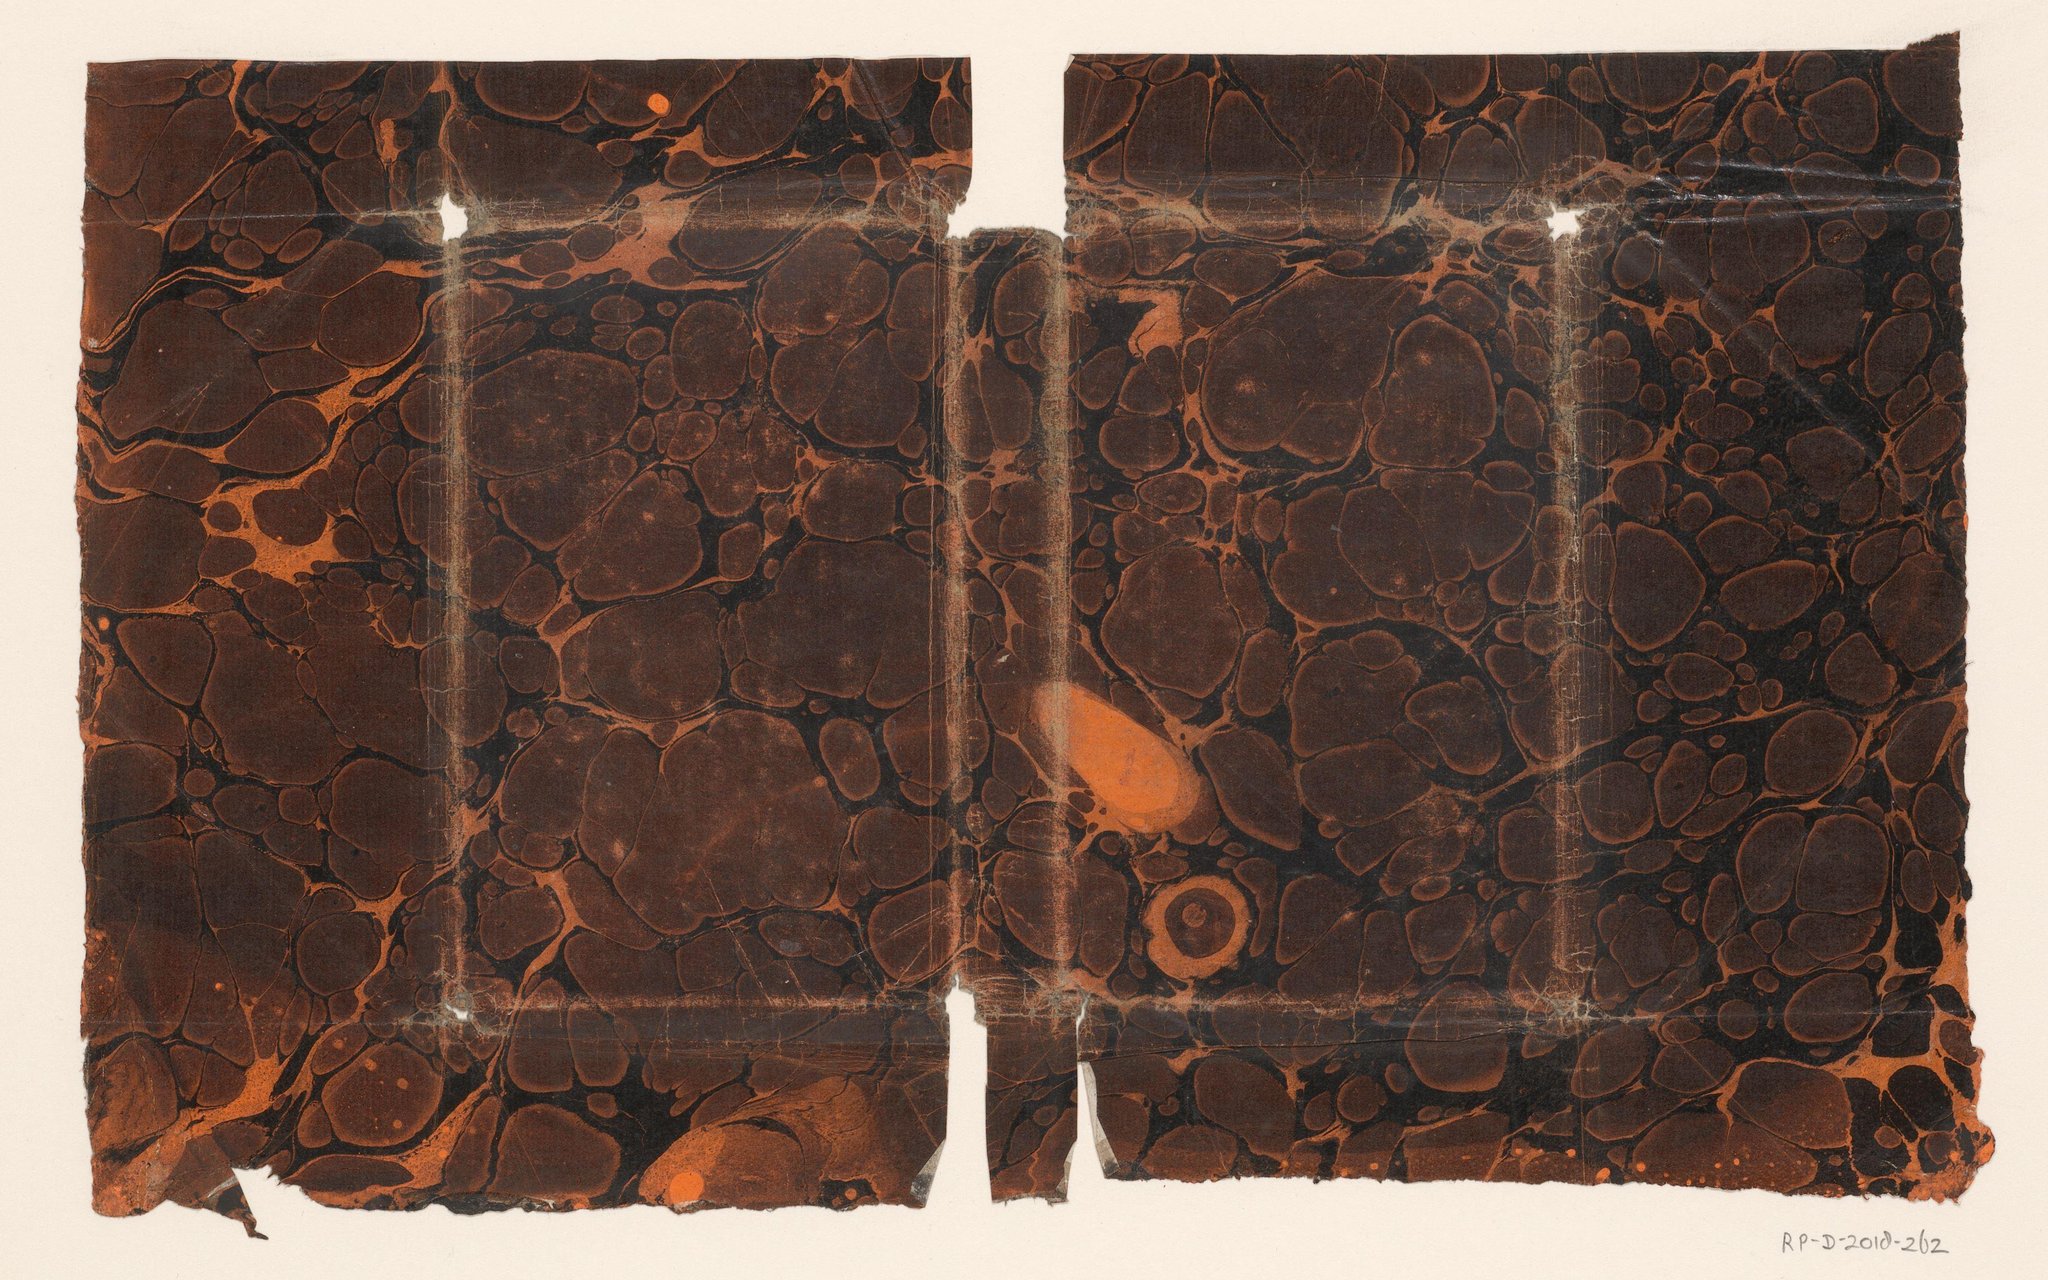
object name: marbled paper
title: Kiezelmarmer in roodbruin, zwart en oranje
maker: Anonymous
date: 1700-1900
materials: paint, paper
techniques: marbling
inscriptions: collector's mark: Lugt 2228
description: Kiezelmarmer in roodbruin, zwart en oranje. Gebruikt als omslag, met insnijdingen bij de rug.